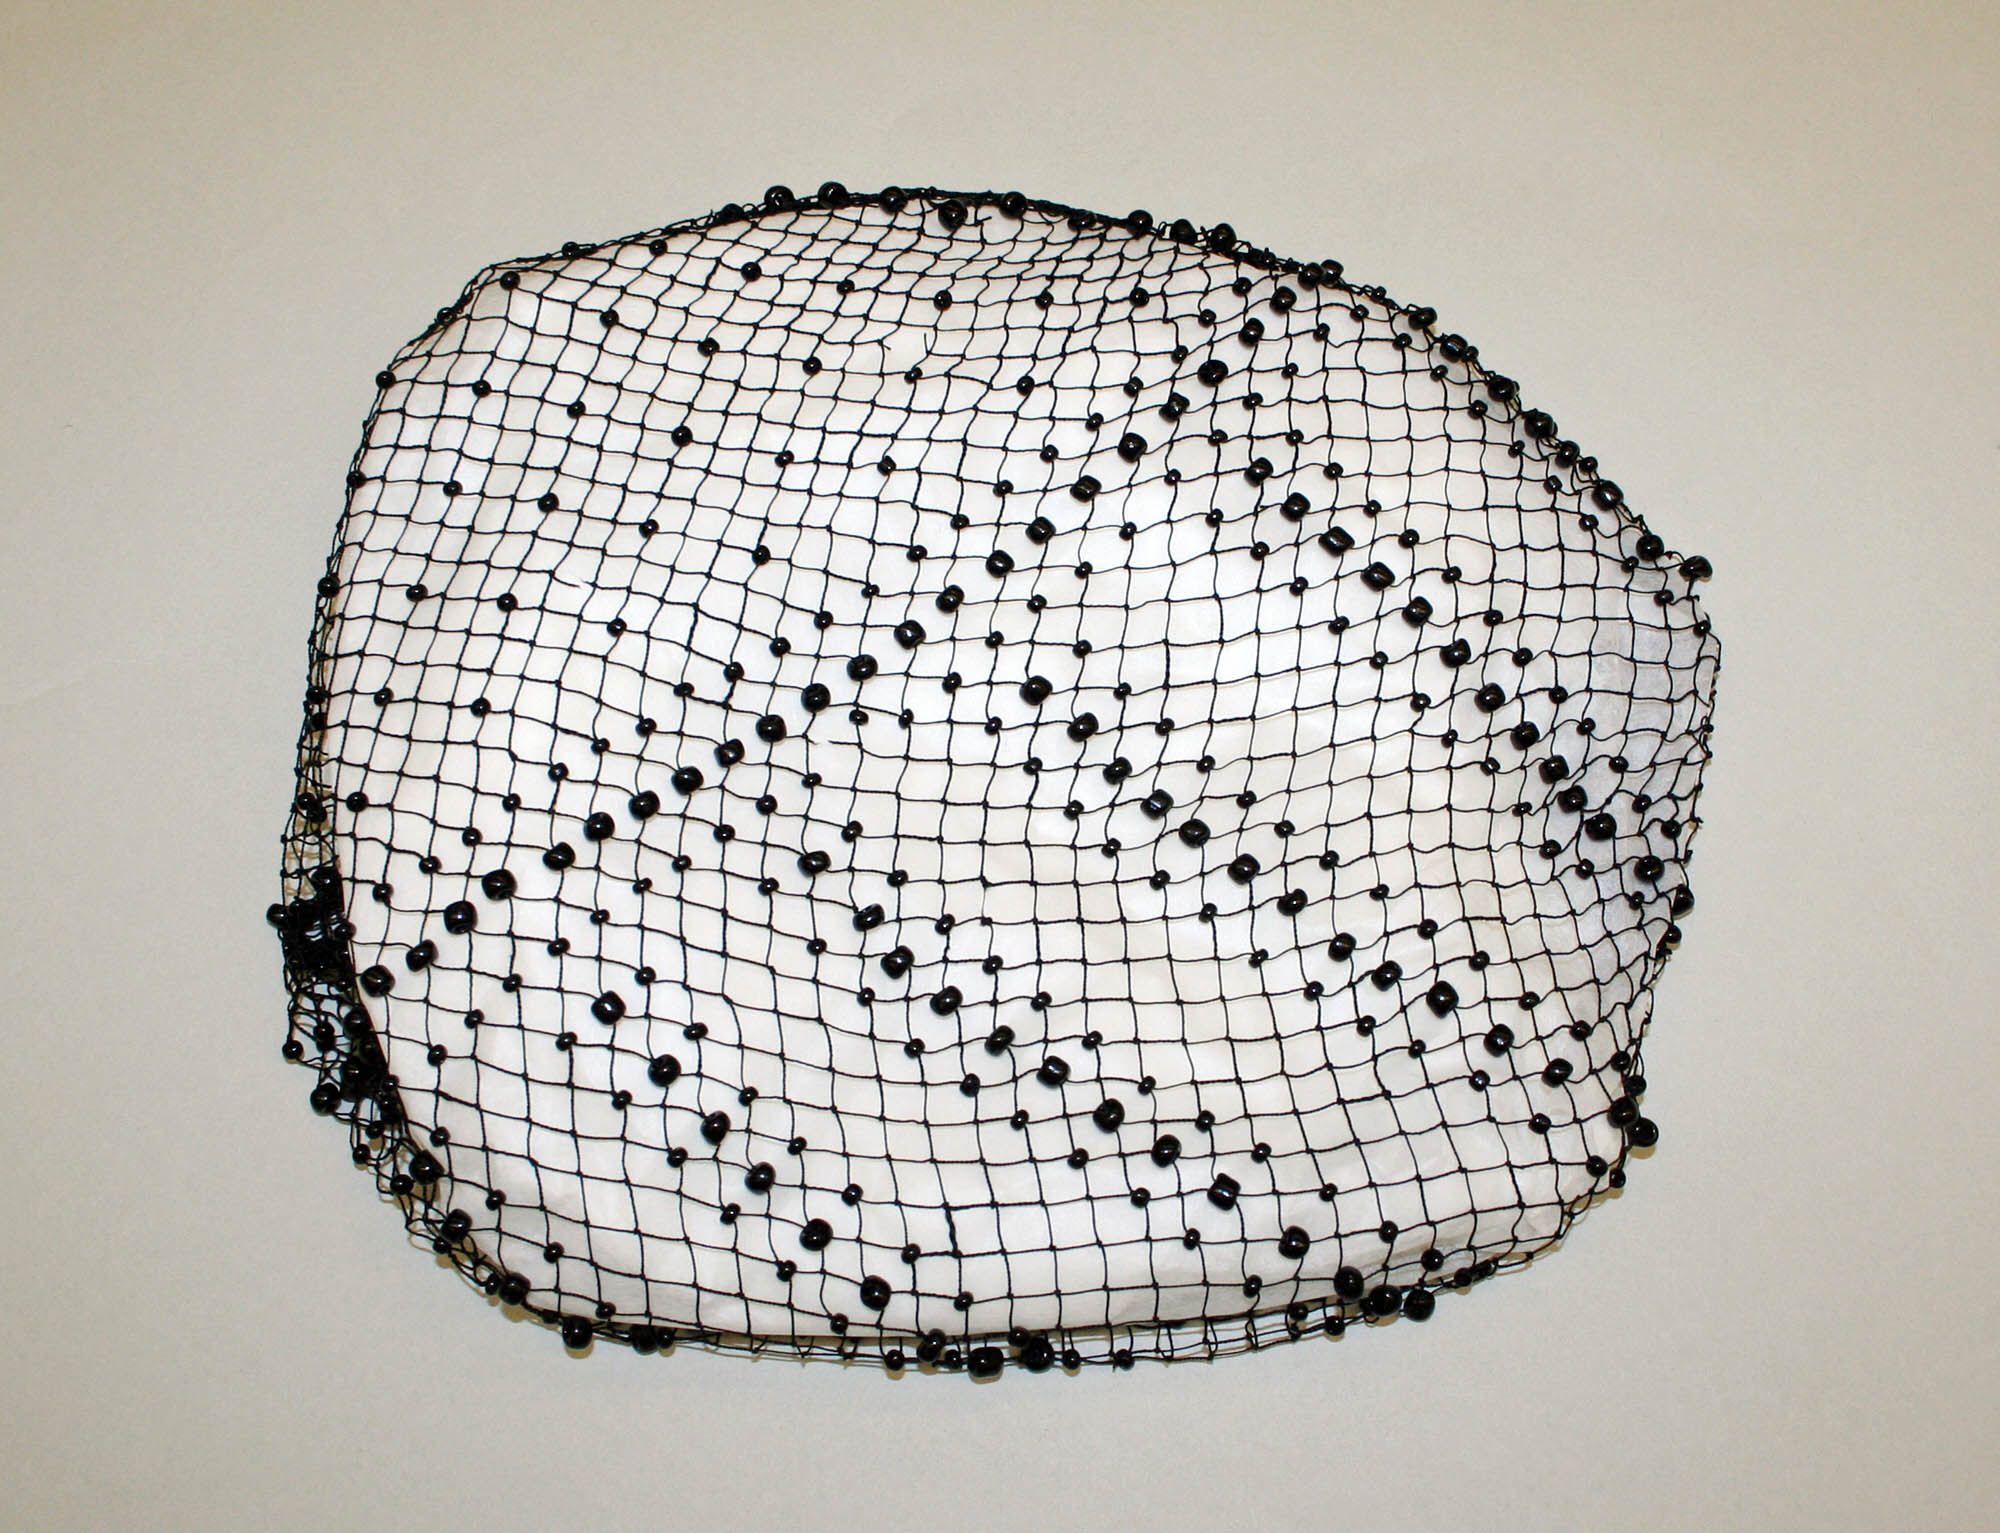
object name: snood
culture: american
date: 1870-1879